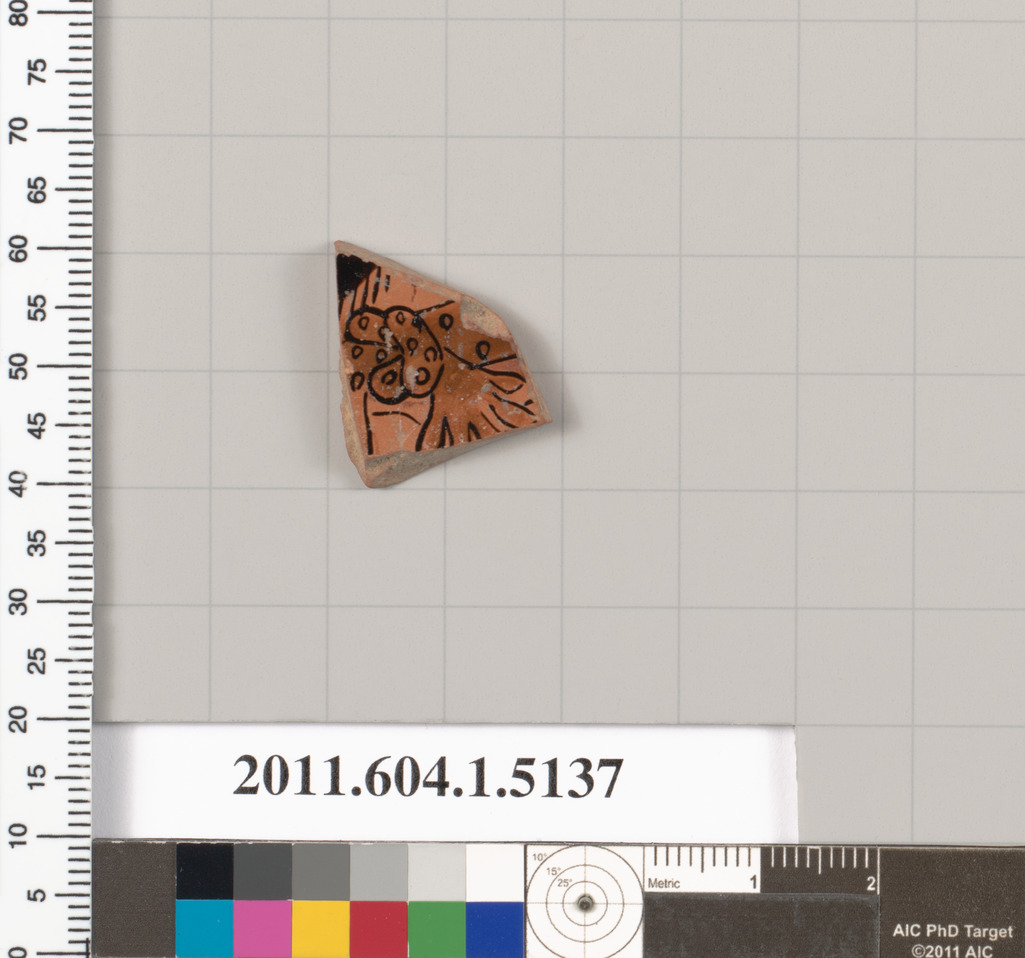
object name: kylix fragment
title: Terracotta fragment of a kylix (drinking cup)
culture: greek, attic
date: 500-480 BCE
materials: terracotta